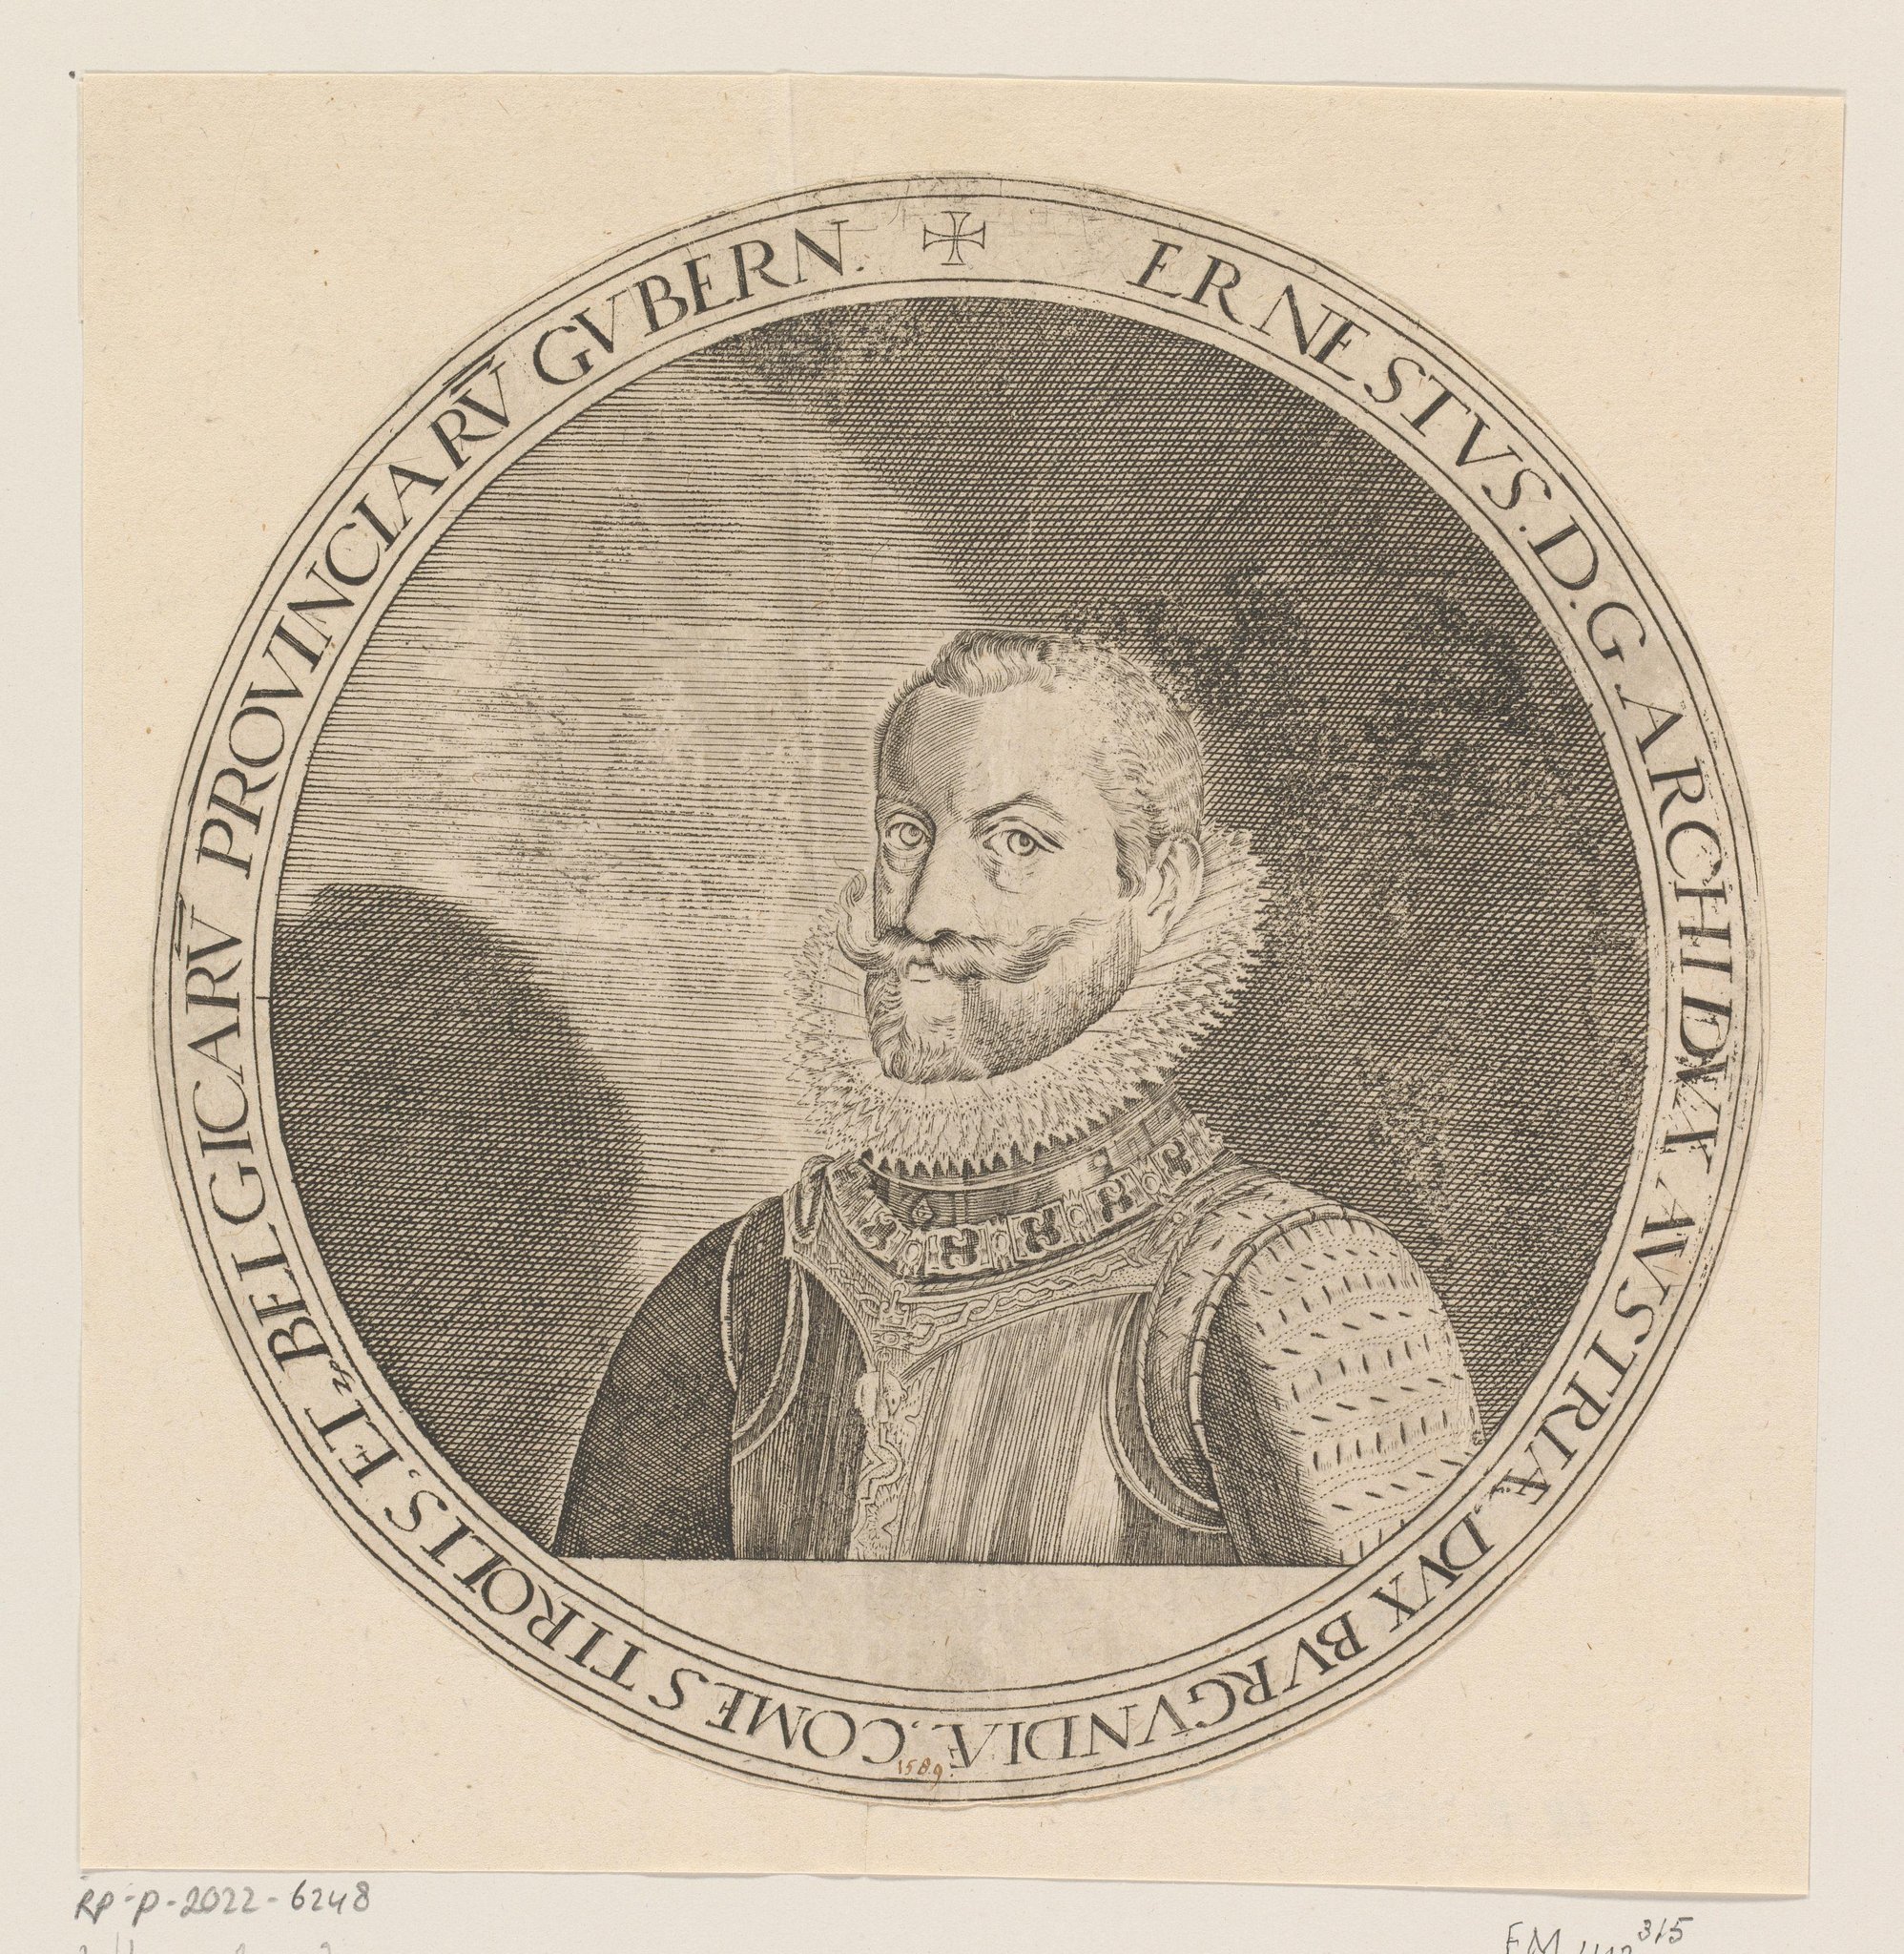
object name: print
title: Portret van Ernst van Oostenrijk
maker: frans hogenberg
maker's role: print maker, publisher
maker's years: 1538-1590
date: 1596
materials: paper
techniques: engraving, etching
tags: vienna, brussels, historical persons, regent, substitute ruler; viceroy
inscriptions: number: ‘1589.’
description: Prent waarschijnlijk uit: Meteren, Emanuel van. Historia, Oder Eigentliche und warhaffte Beschreibung aller fürnehmen Krigshändel (…). S.l.s.n., 1596. Of uit: Meteren, Emanuel van. Historia unnd Abcontrafeytungh fürnemlich der Niderlendischer Geschichten und Kriegßhendelen. S.l., s.n., 1596, dl. 2. Nogmaals, met boekdruk op verso, uitgegeven in: Meteren, Emanuel van. Historia Belgica Nostri Potissimum Temporis Belgii (…). S.l., s.n., 1598, 1610.